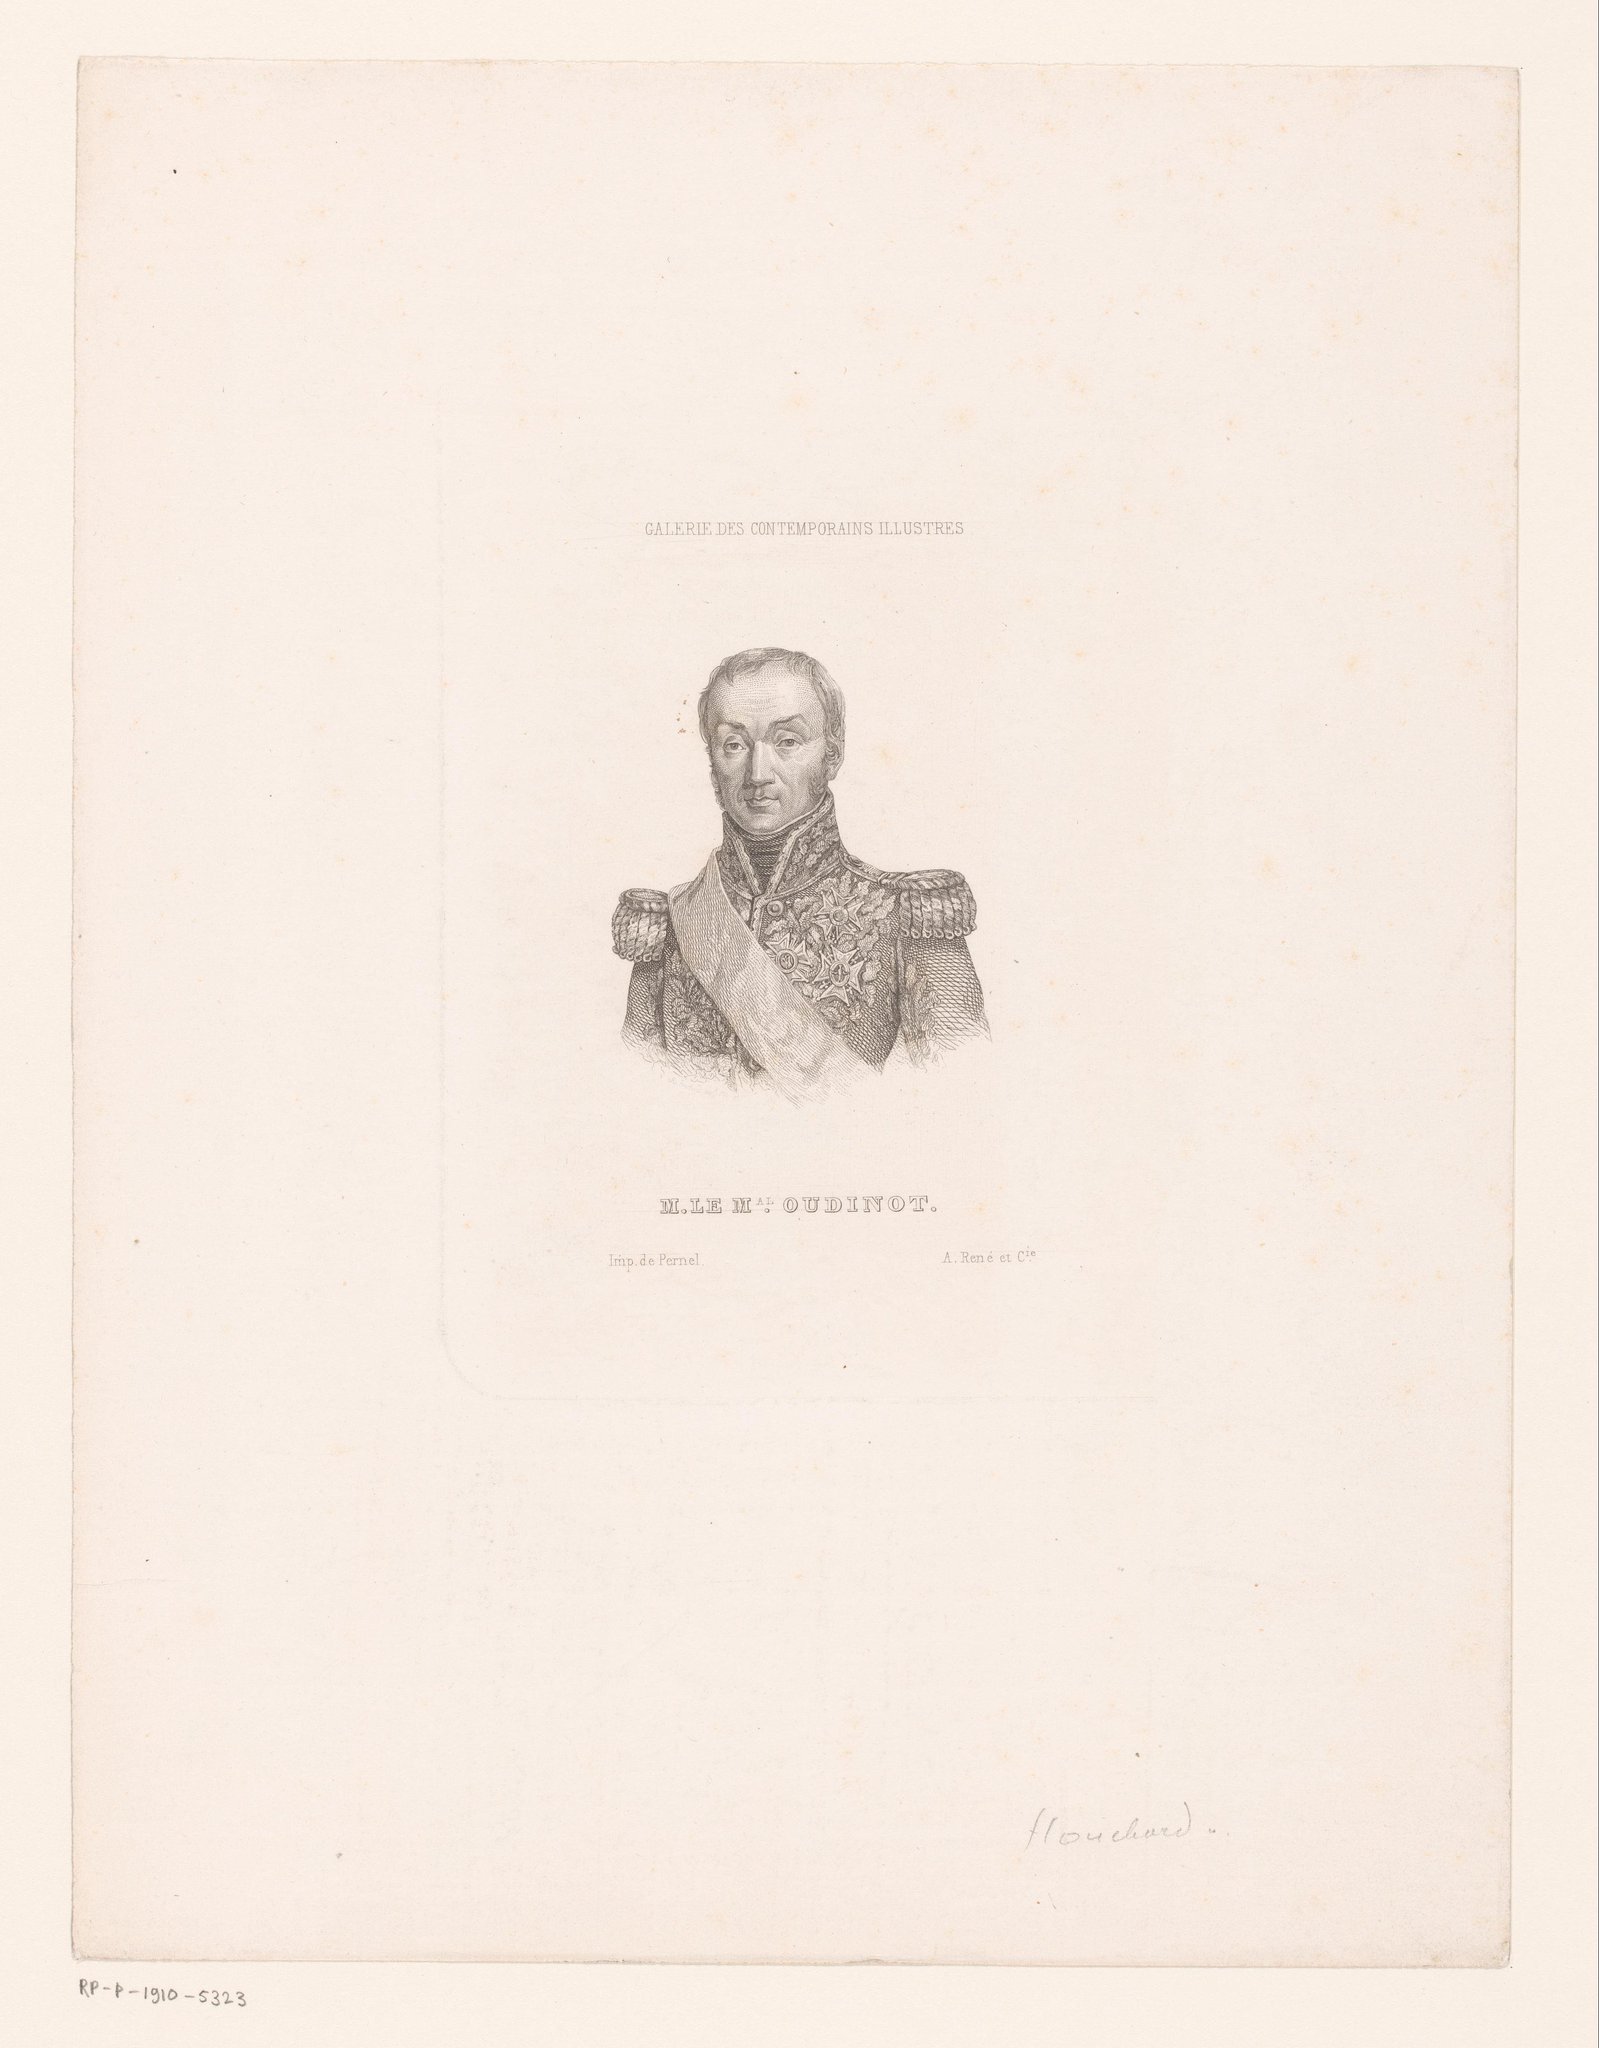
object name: print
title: Portretten van bekende tijdgenoten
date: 1842-1845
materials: paper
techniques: etching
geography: paris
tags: paris, commander-in-chief, general, marshal, historical persons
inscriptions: collector's mark: Lugt 2228